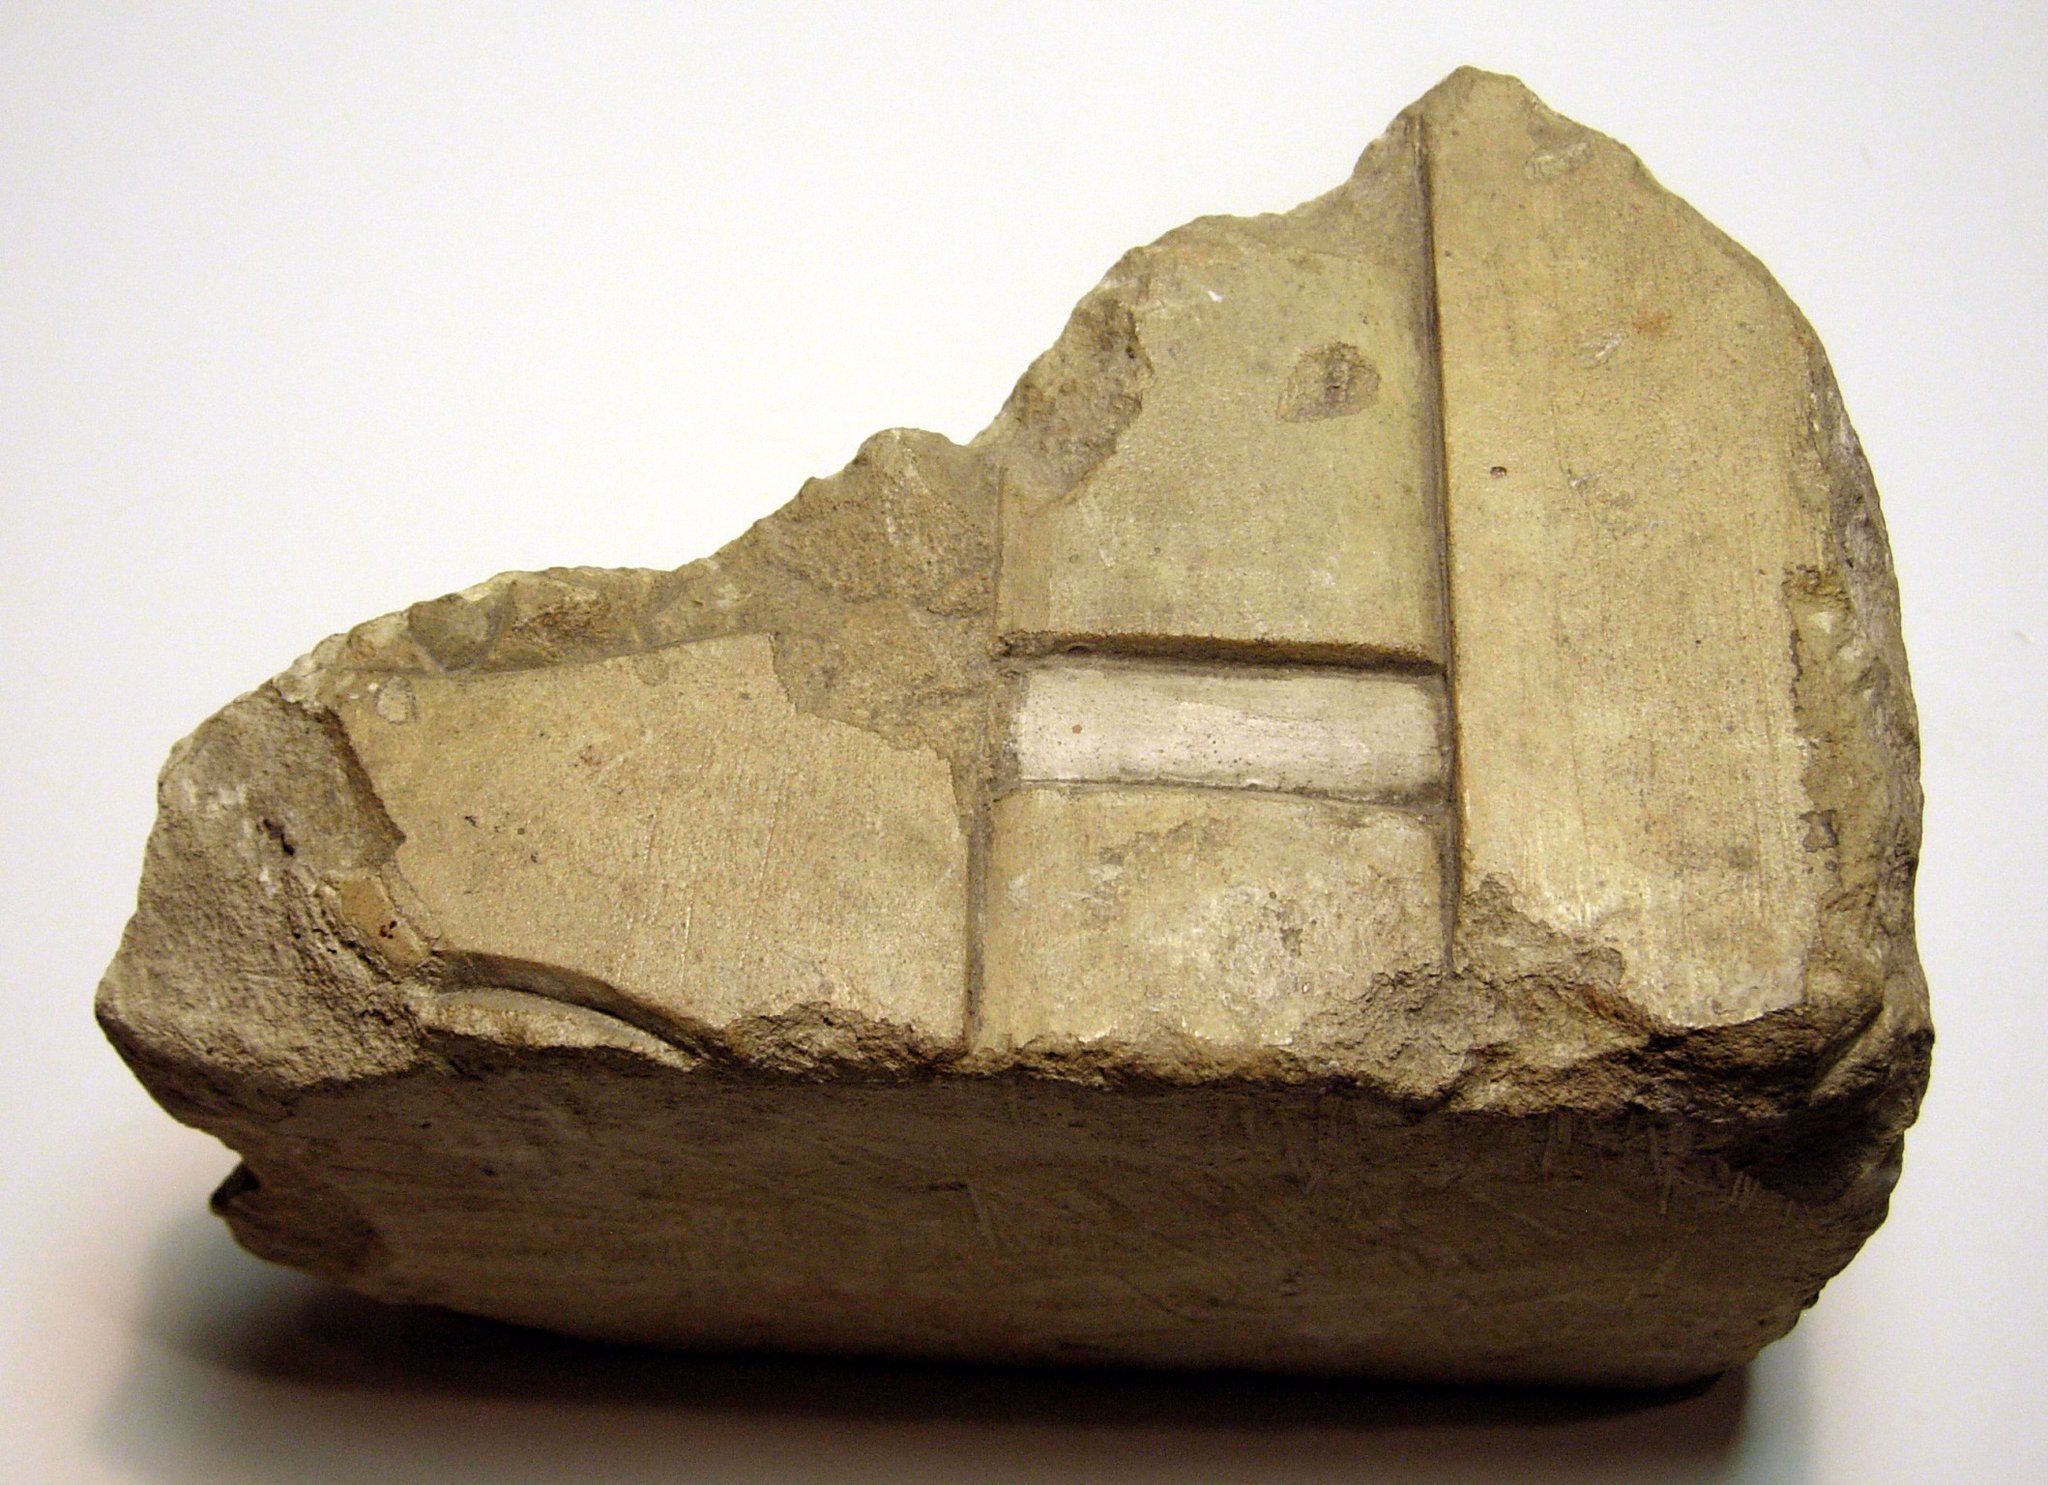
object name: relief, tomb of nespekashuty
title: Raised relief fragment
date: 664-610 BCE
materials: limestone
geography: egypt